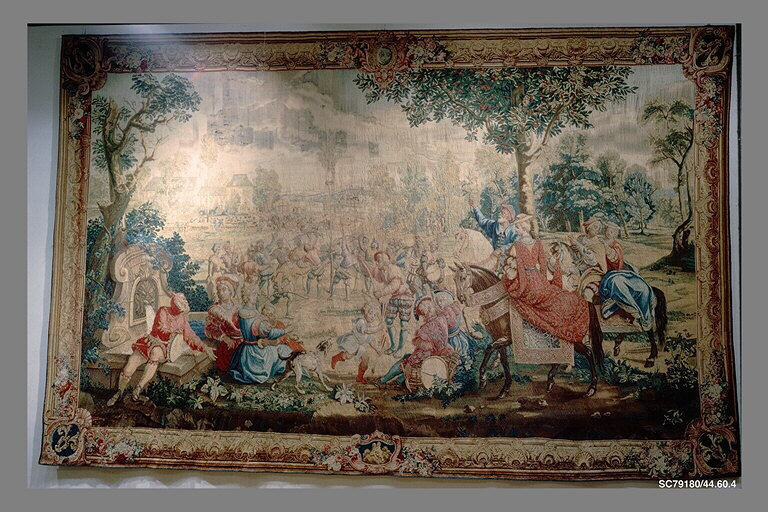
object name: tapestry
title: May from a set of The Months of Lucas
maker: master of the months of lucas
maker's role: designer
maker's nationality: netherlandish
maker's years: 1535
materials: silk, wool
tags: men,women,dogs,horses